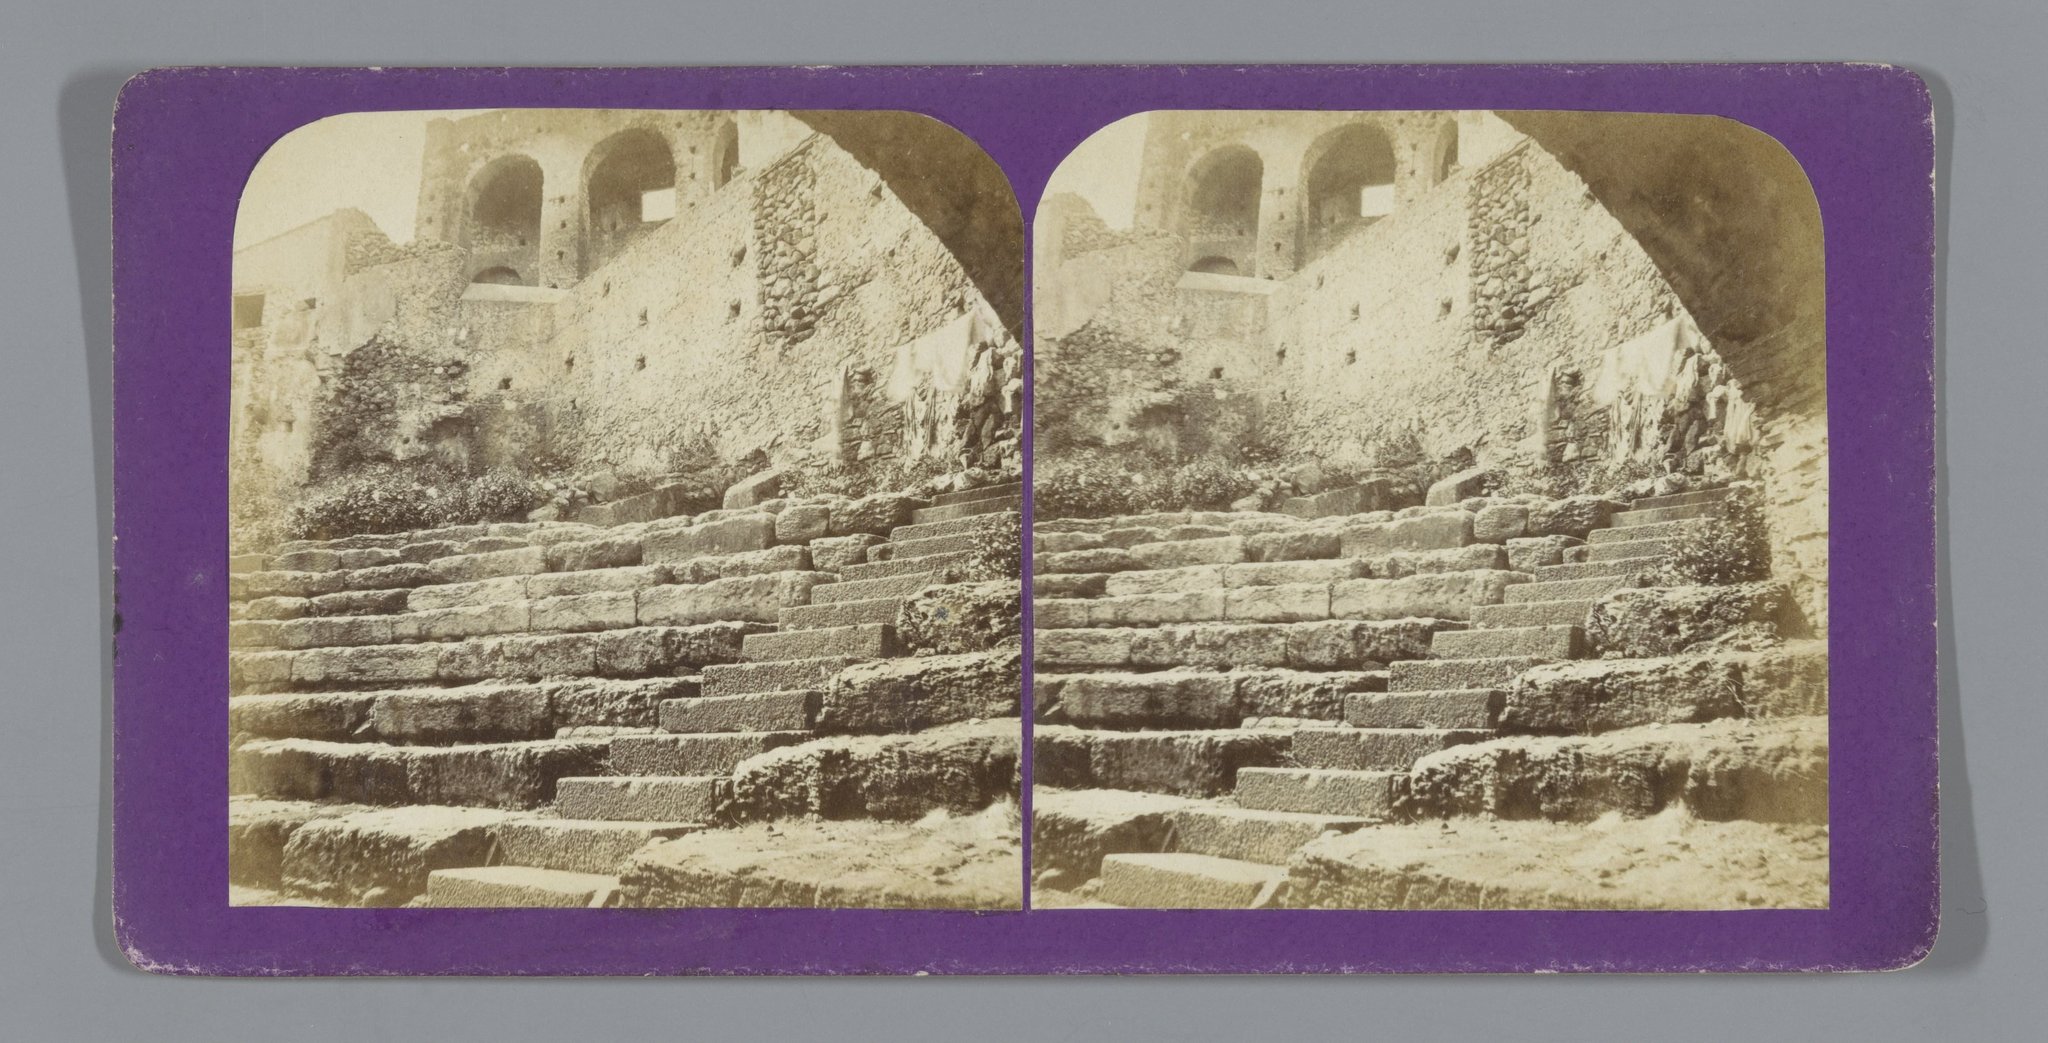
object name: stereograph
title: Gradins de la salle au théatre grec Catane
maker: jean andrieu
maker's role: fotograaf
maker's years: 1816-1872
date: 1862-1876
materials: cardboard, paper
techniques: albumen print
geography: catania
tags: ruin of a building ~ architecture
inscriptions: title: ‘1378 Gradins de la salle au théatre grec Catane’